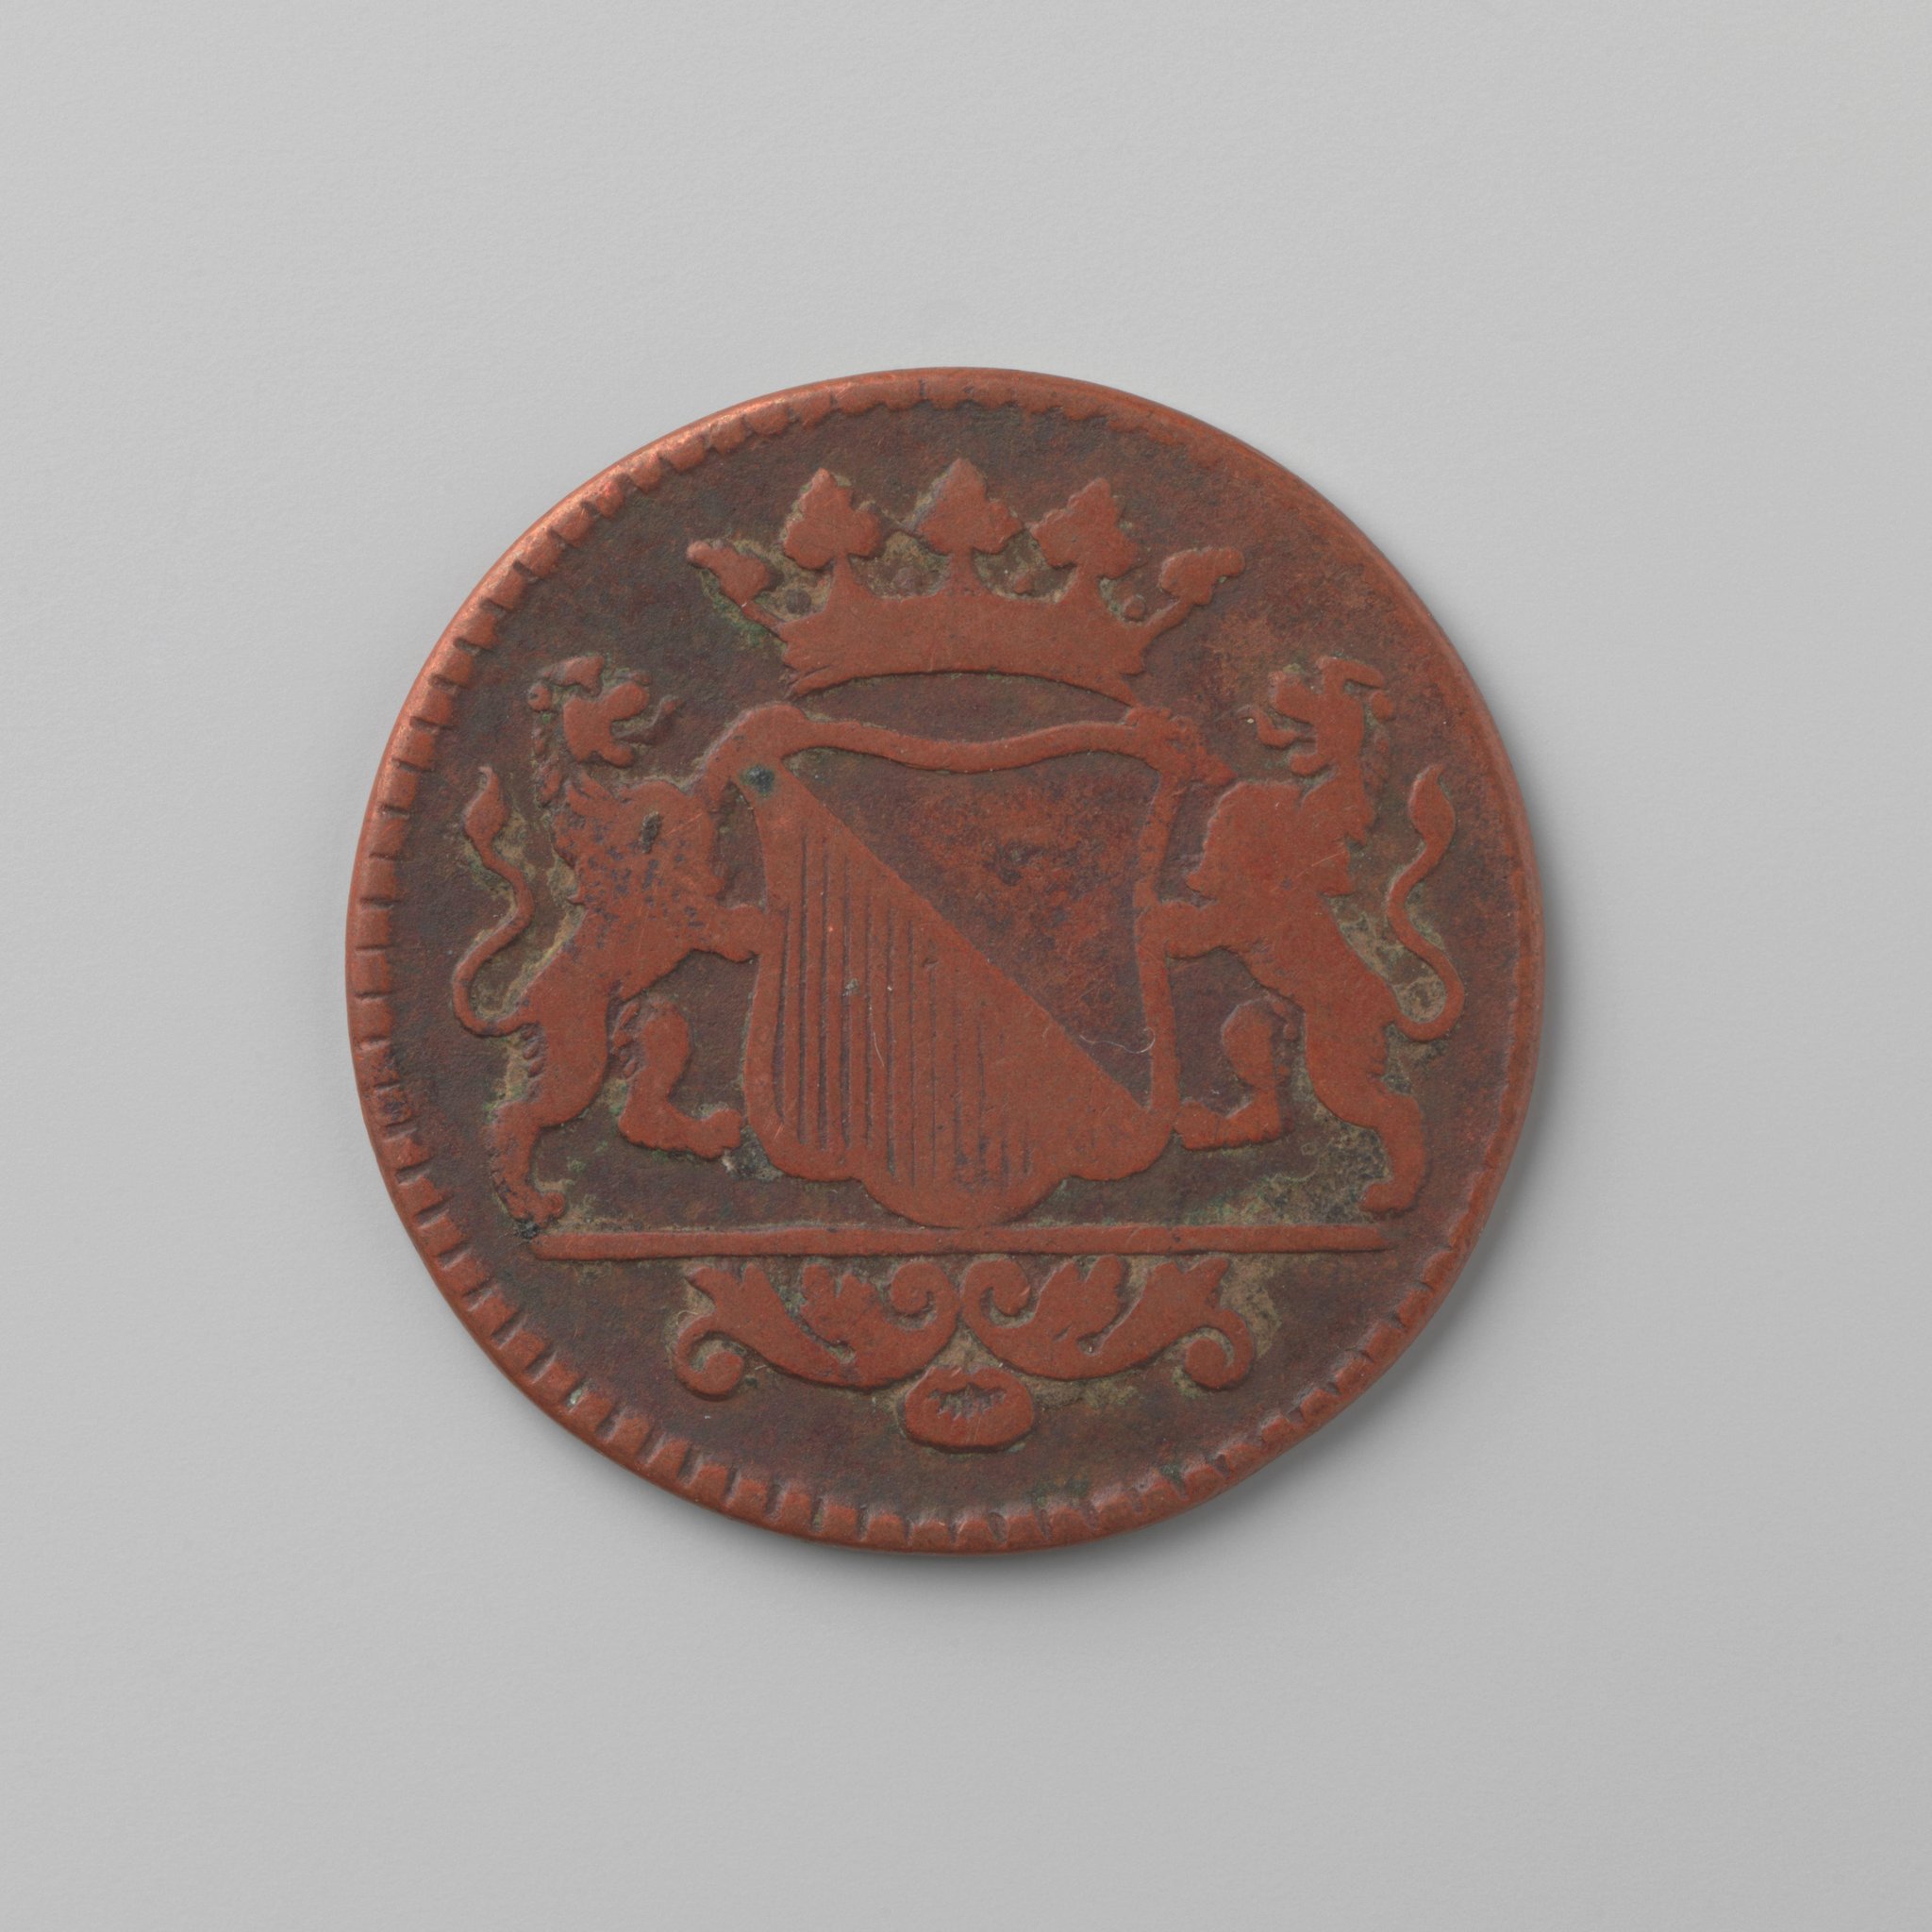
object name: coin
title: Duit van de VOC uit de stad Utrecht,1742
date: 1742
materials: copper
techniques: striking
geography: utrecht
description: Koperen munt. Voorzijde: op balk, waaronder guirlande, geplaatst, door twee leeuwen gehouden gekroond wapenschild van de stad Utrecht. Keerzijde: monogram van de VOC, waarboven muntteken en waaronder jaartal. Gladde rand.